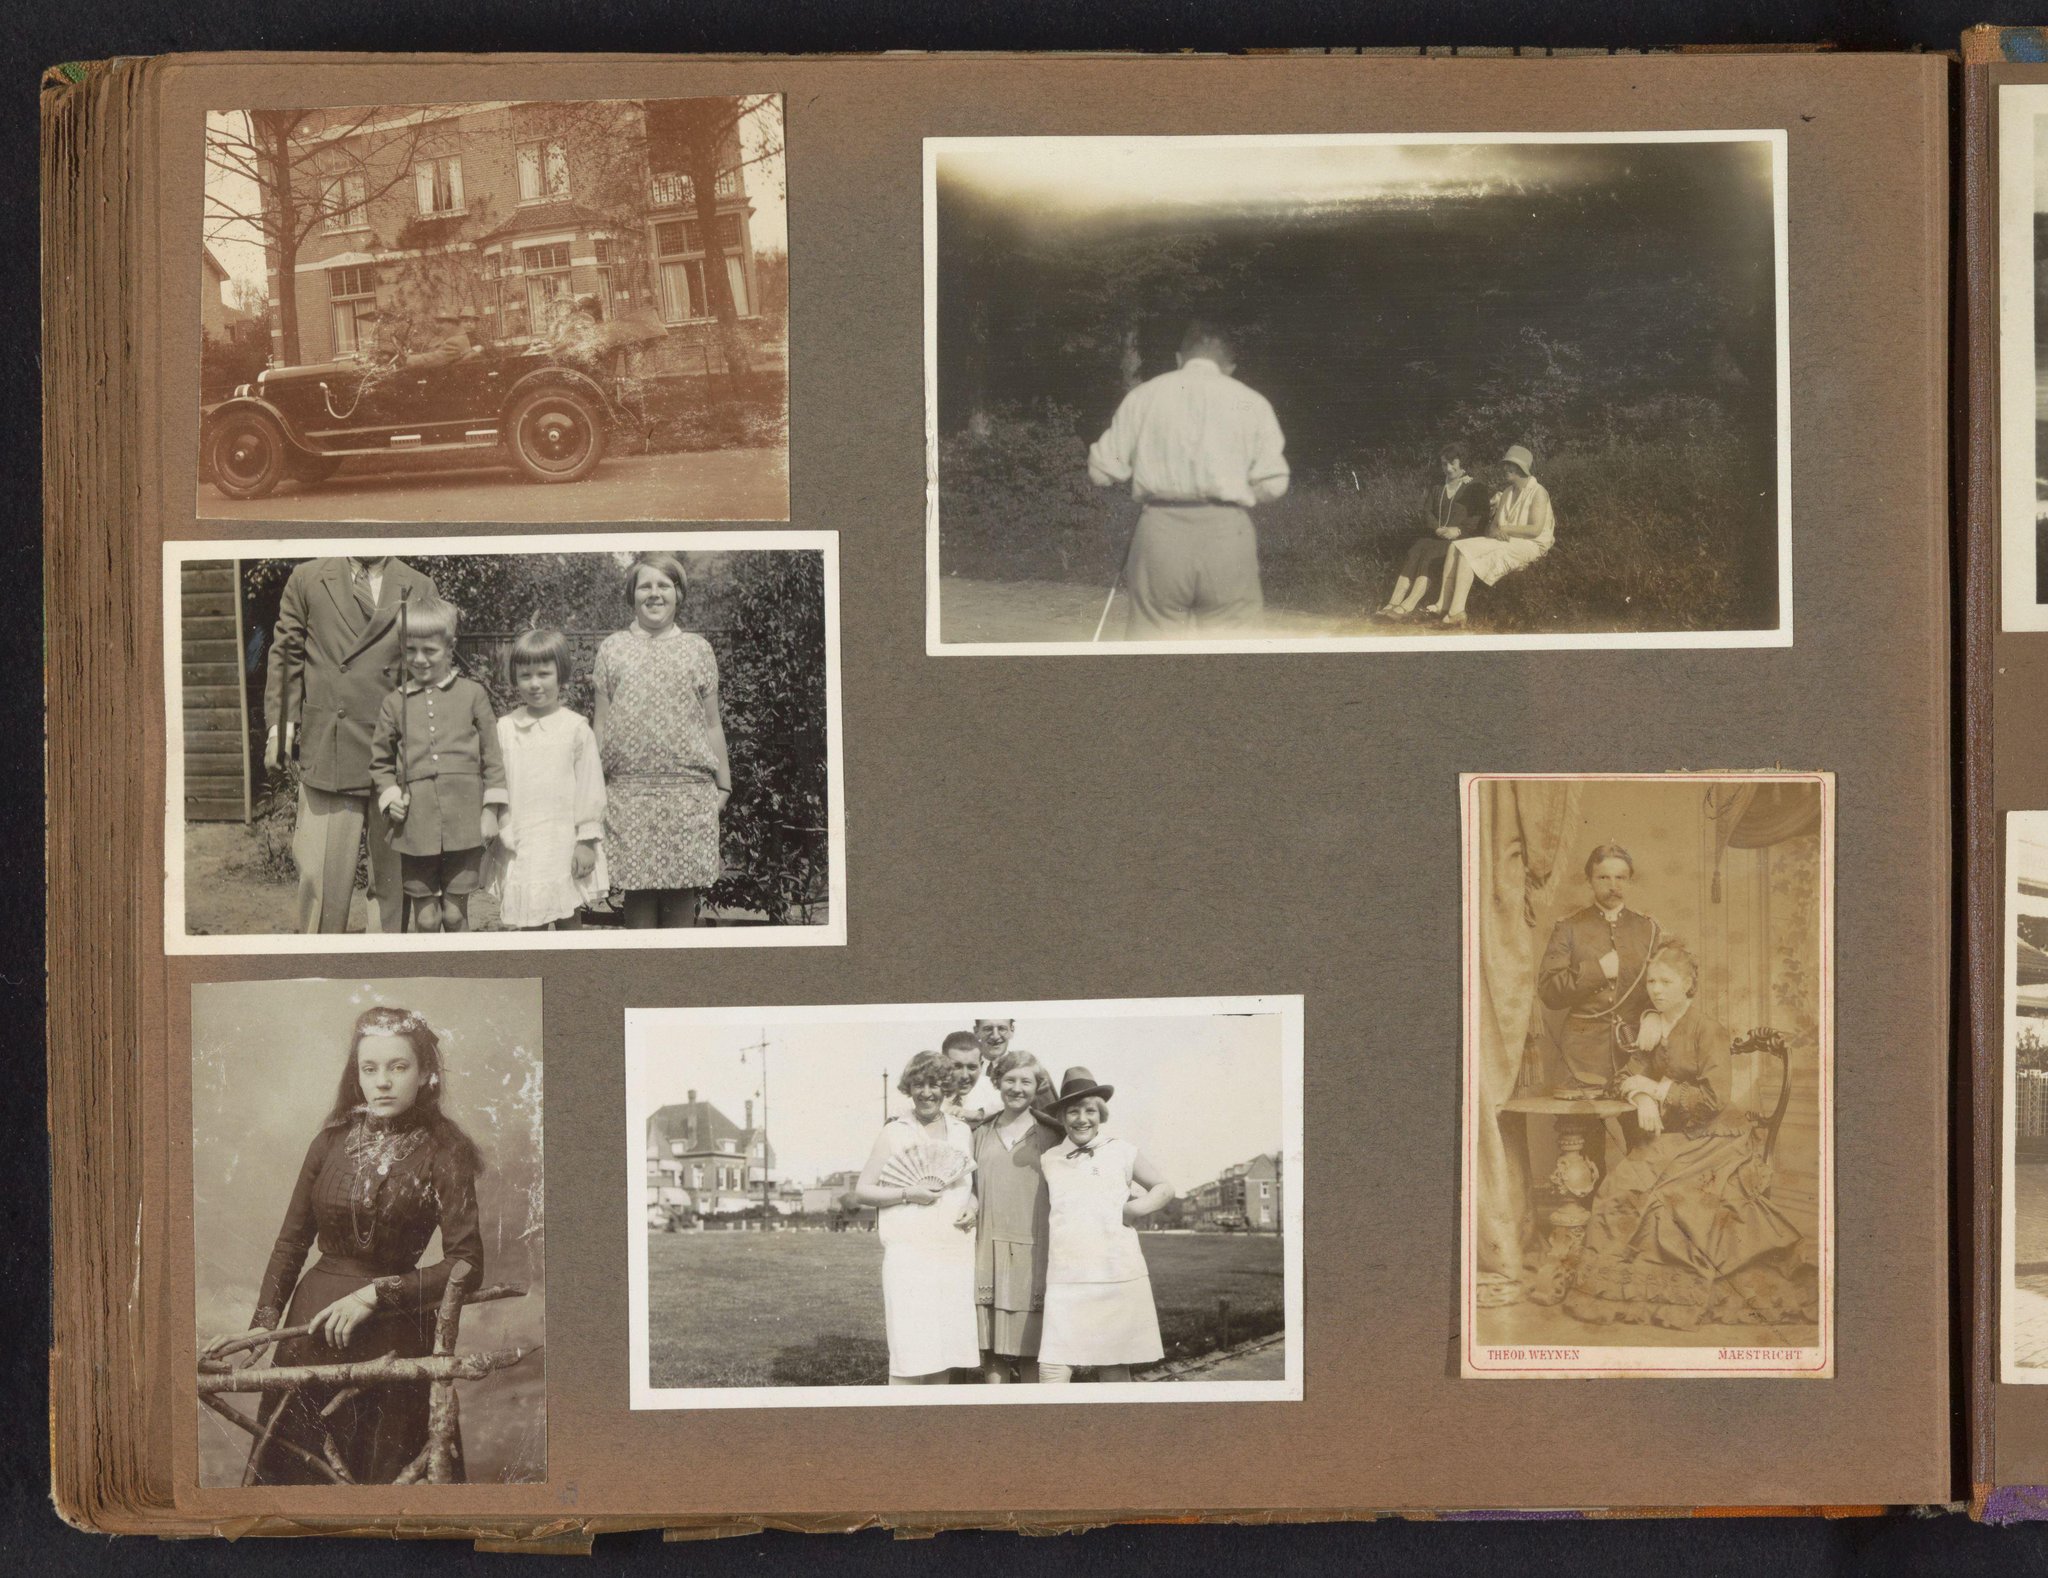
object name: album leaf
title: Gezelschappen en portretten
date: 1870-1925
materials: cardboard, photographic support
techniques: albumen print, gelatin silver print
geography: netherlands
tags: adult woman, studio requisites ~ photographer, photographer at work - cc - out of doors, adult man, child, automobile, netherlands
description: Albumblad met foto's van onbekende personen, onder meer van een gezelschap op een grasveld in een stad en van drie kinderen en een man. Ook een opname van een man, op de rug gezien, die vermoedelijk een foto maakt van twee vrouwen. Voorts een portret van een meisje en een studioportret van een stel, de man een militair. Onderdeel van Fotoalbum van een onbekende Nederlandse familie met connecties in Suriname en Nederlands-Indië (2).